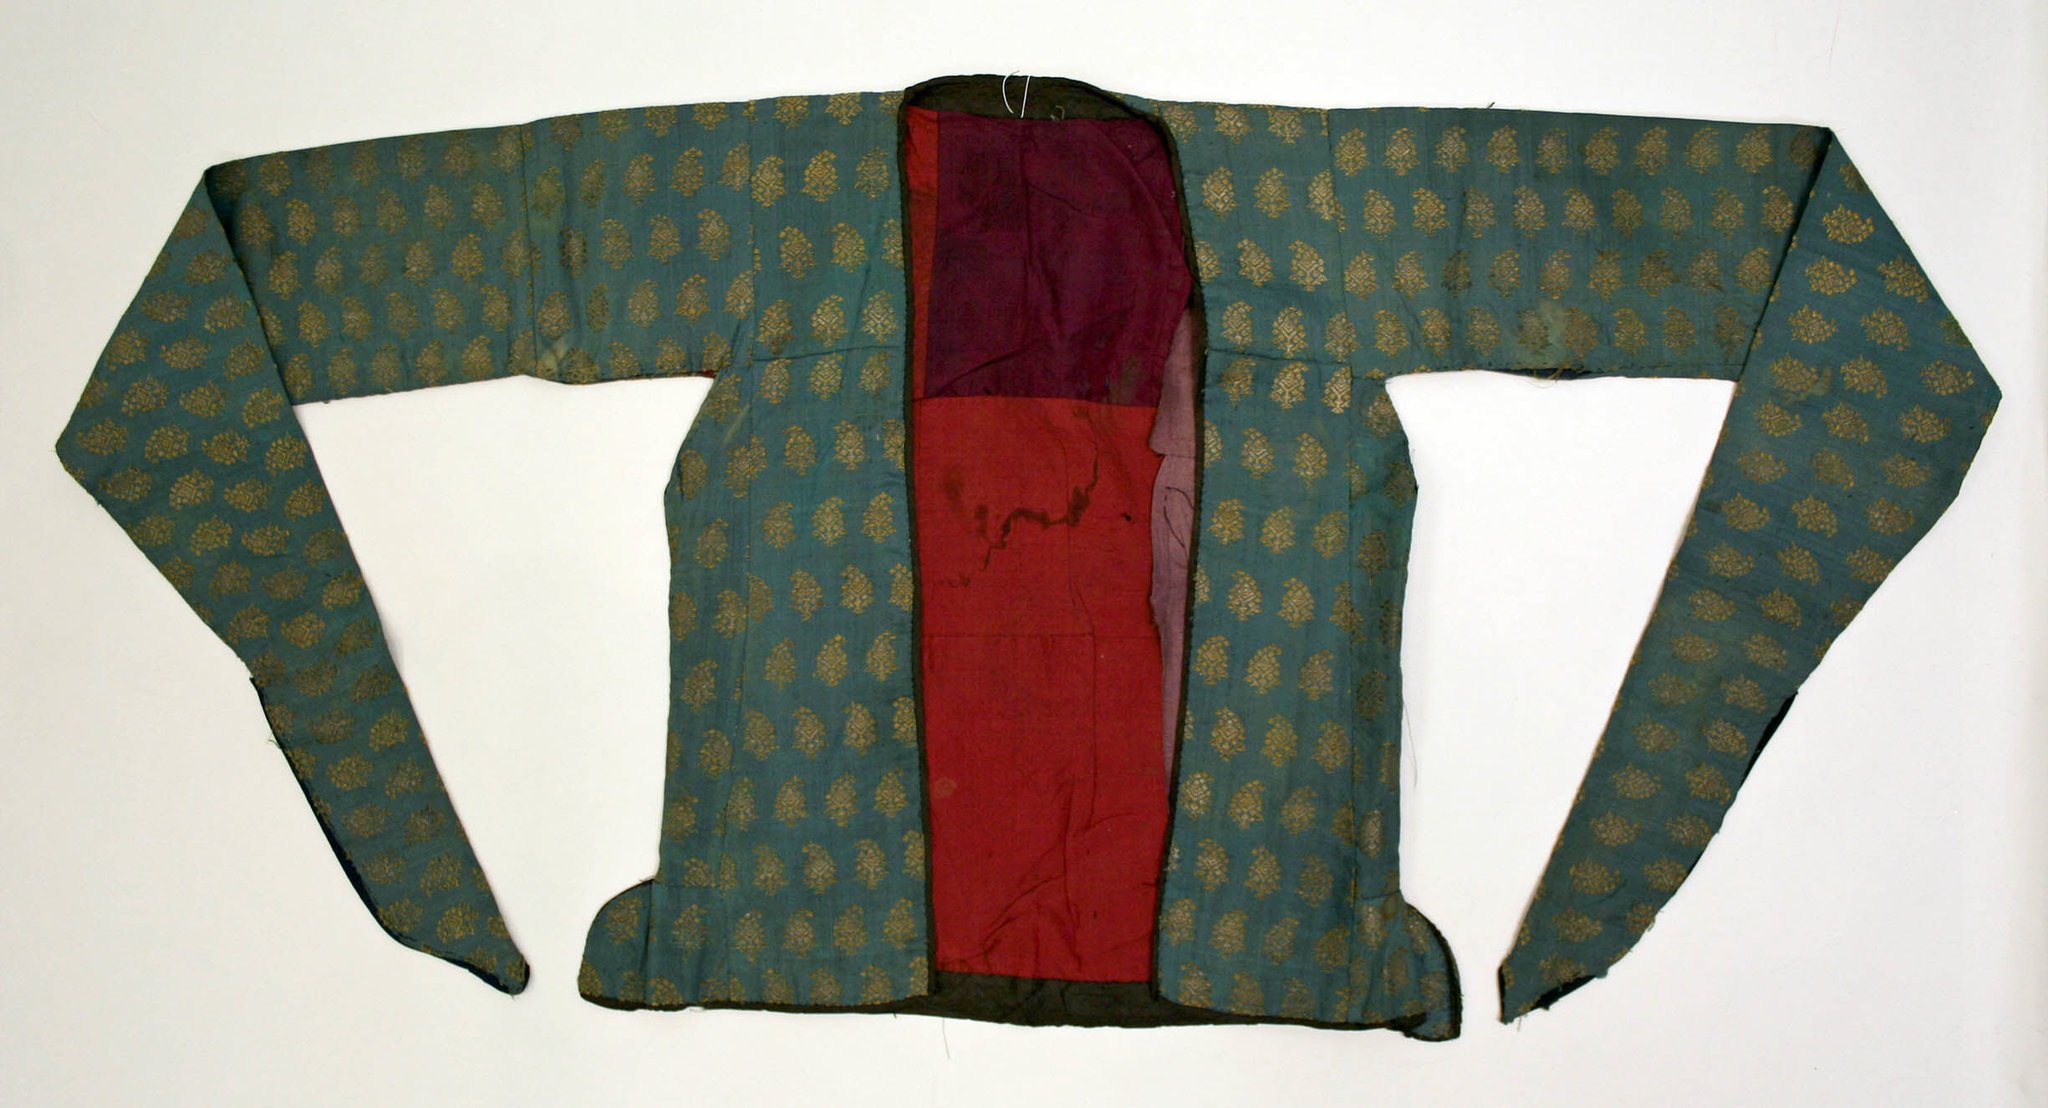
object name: jacket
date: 1801-1900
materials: metal thread, silk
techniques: brocade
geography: iran